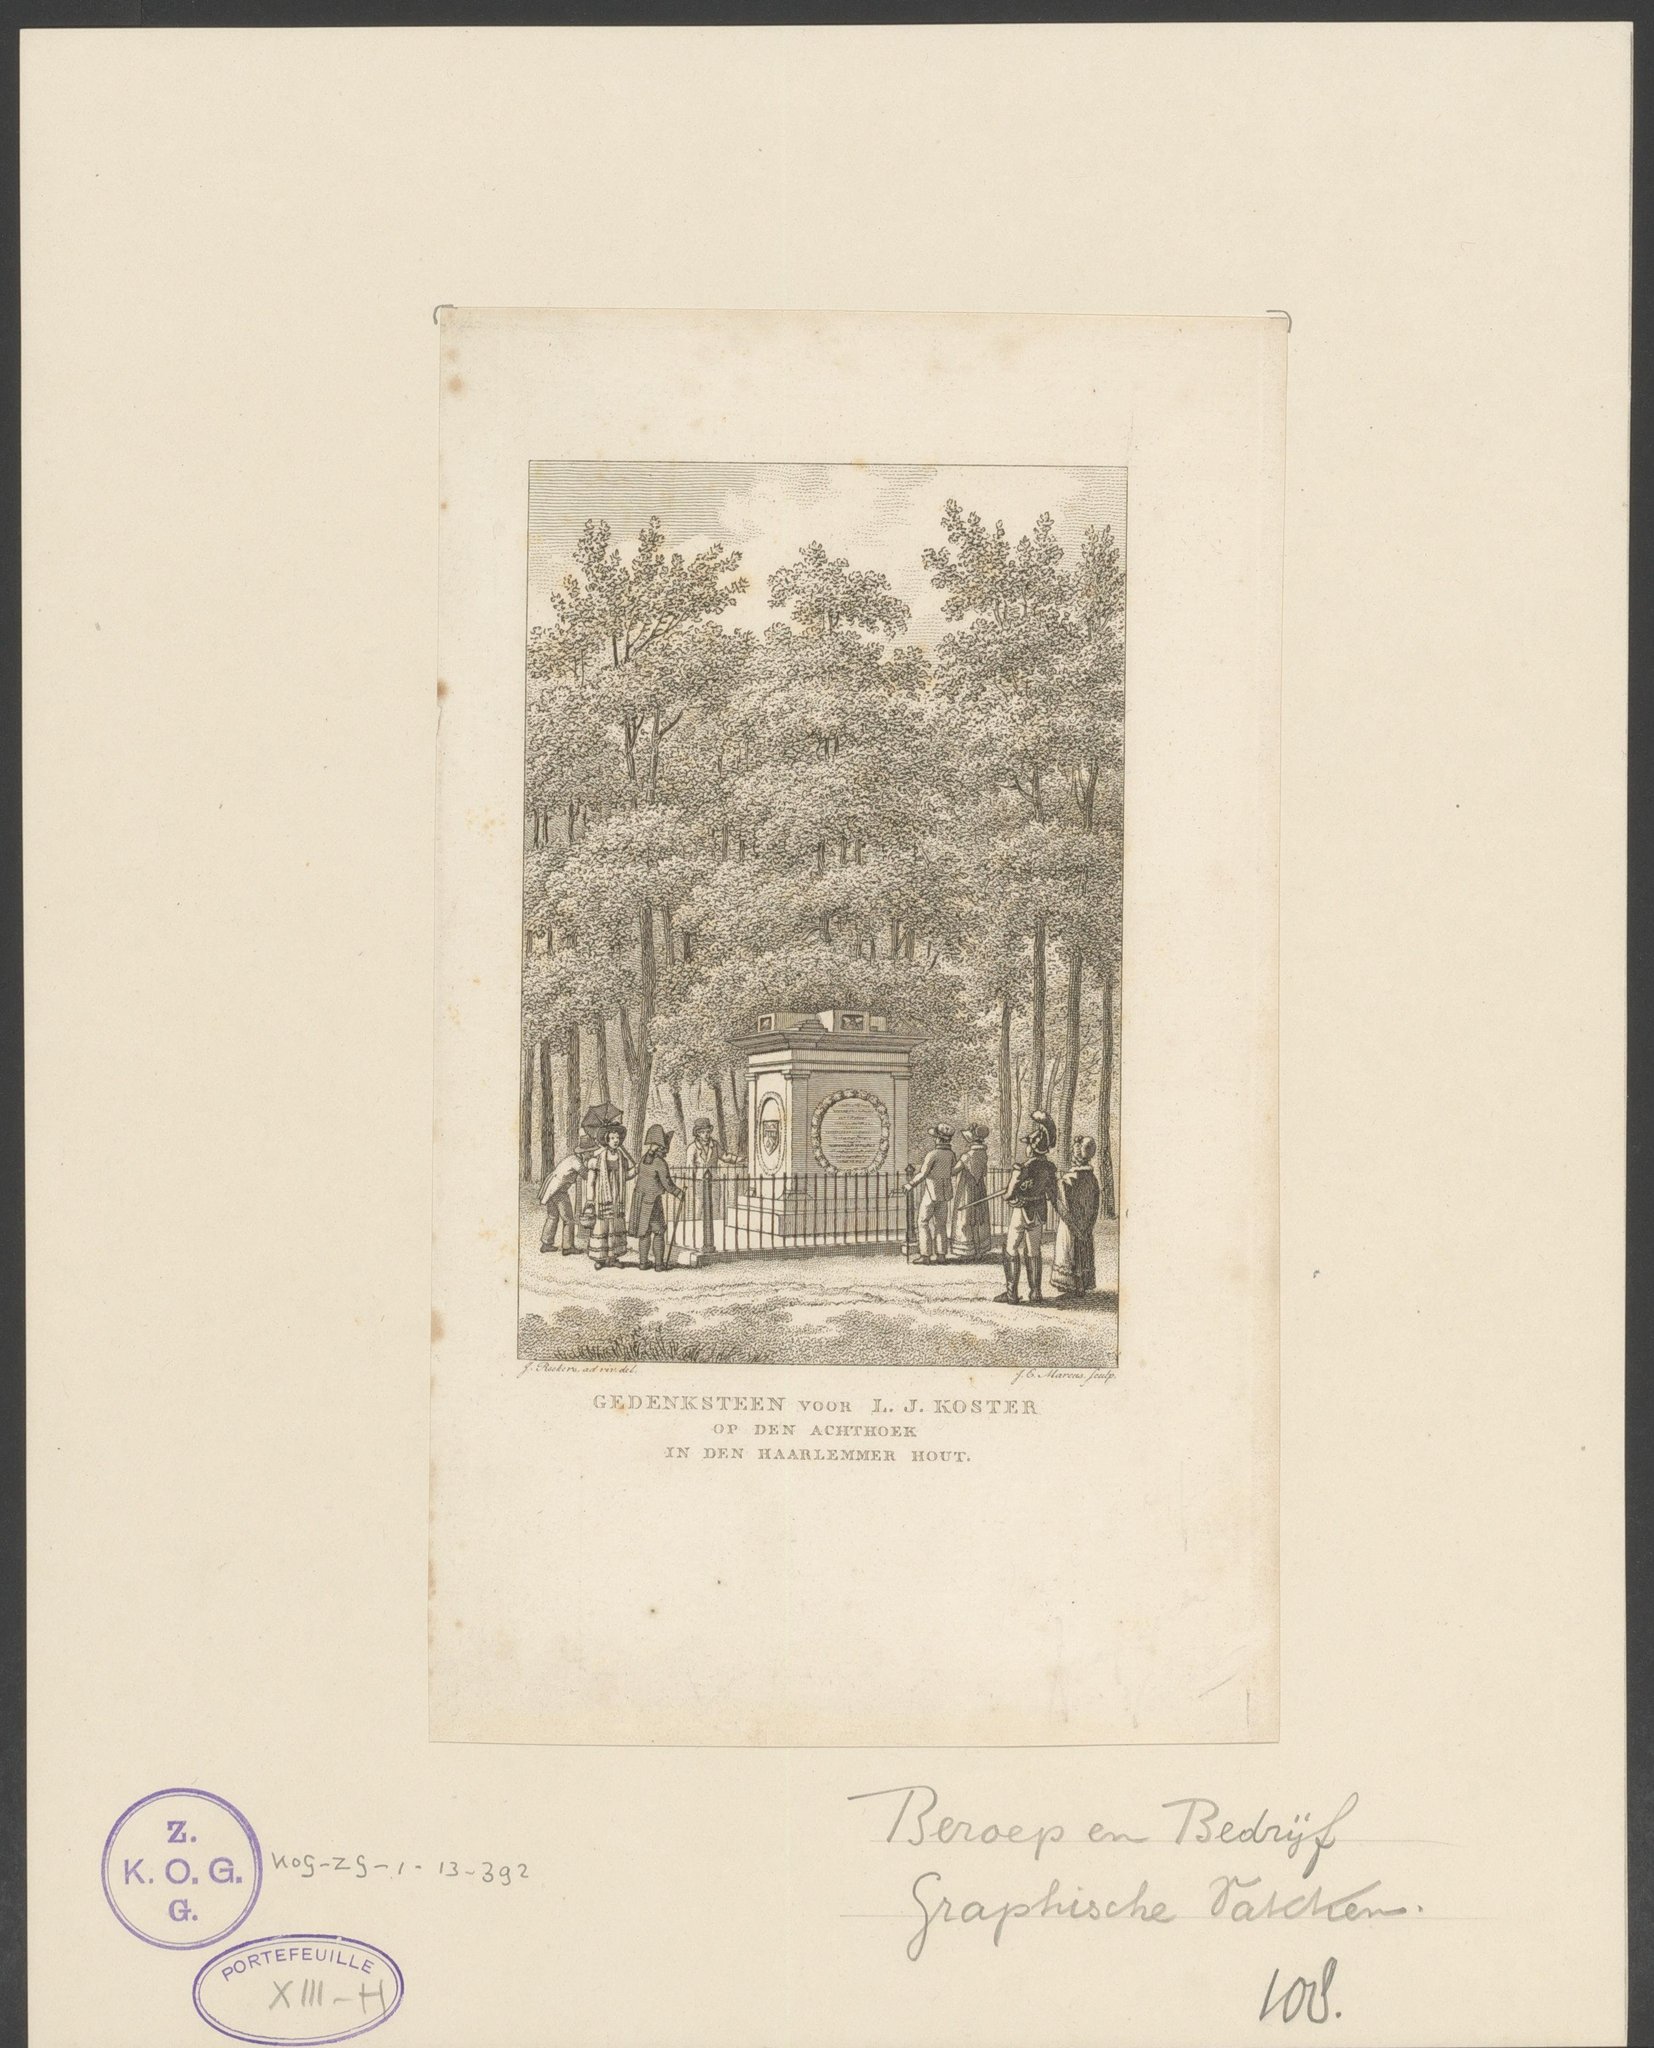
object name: print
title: Gedenkmonument Laurens Janszoon Coster, te Haarlem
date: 1824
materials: paper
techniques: engraving, etching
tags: grave, tomb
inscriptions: collector's mark: Lugt 1641, stamp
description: Monument voor Coster opgericht in de Haarlemmerhout bij de viering van het 400-jarige jubileum op 10-11 juli in 1823 van de uitvinding boekdrukkunst door Laurens Jansz. Coster te Haarlem in 1423. Onderwerpsrubrieken binnen de Atlas Zeden en Gewoonten: Handel, Nijverheid en verkeer, Beroep en bedrijf, Mannelijk, Graphische vakken.